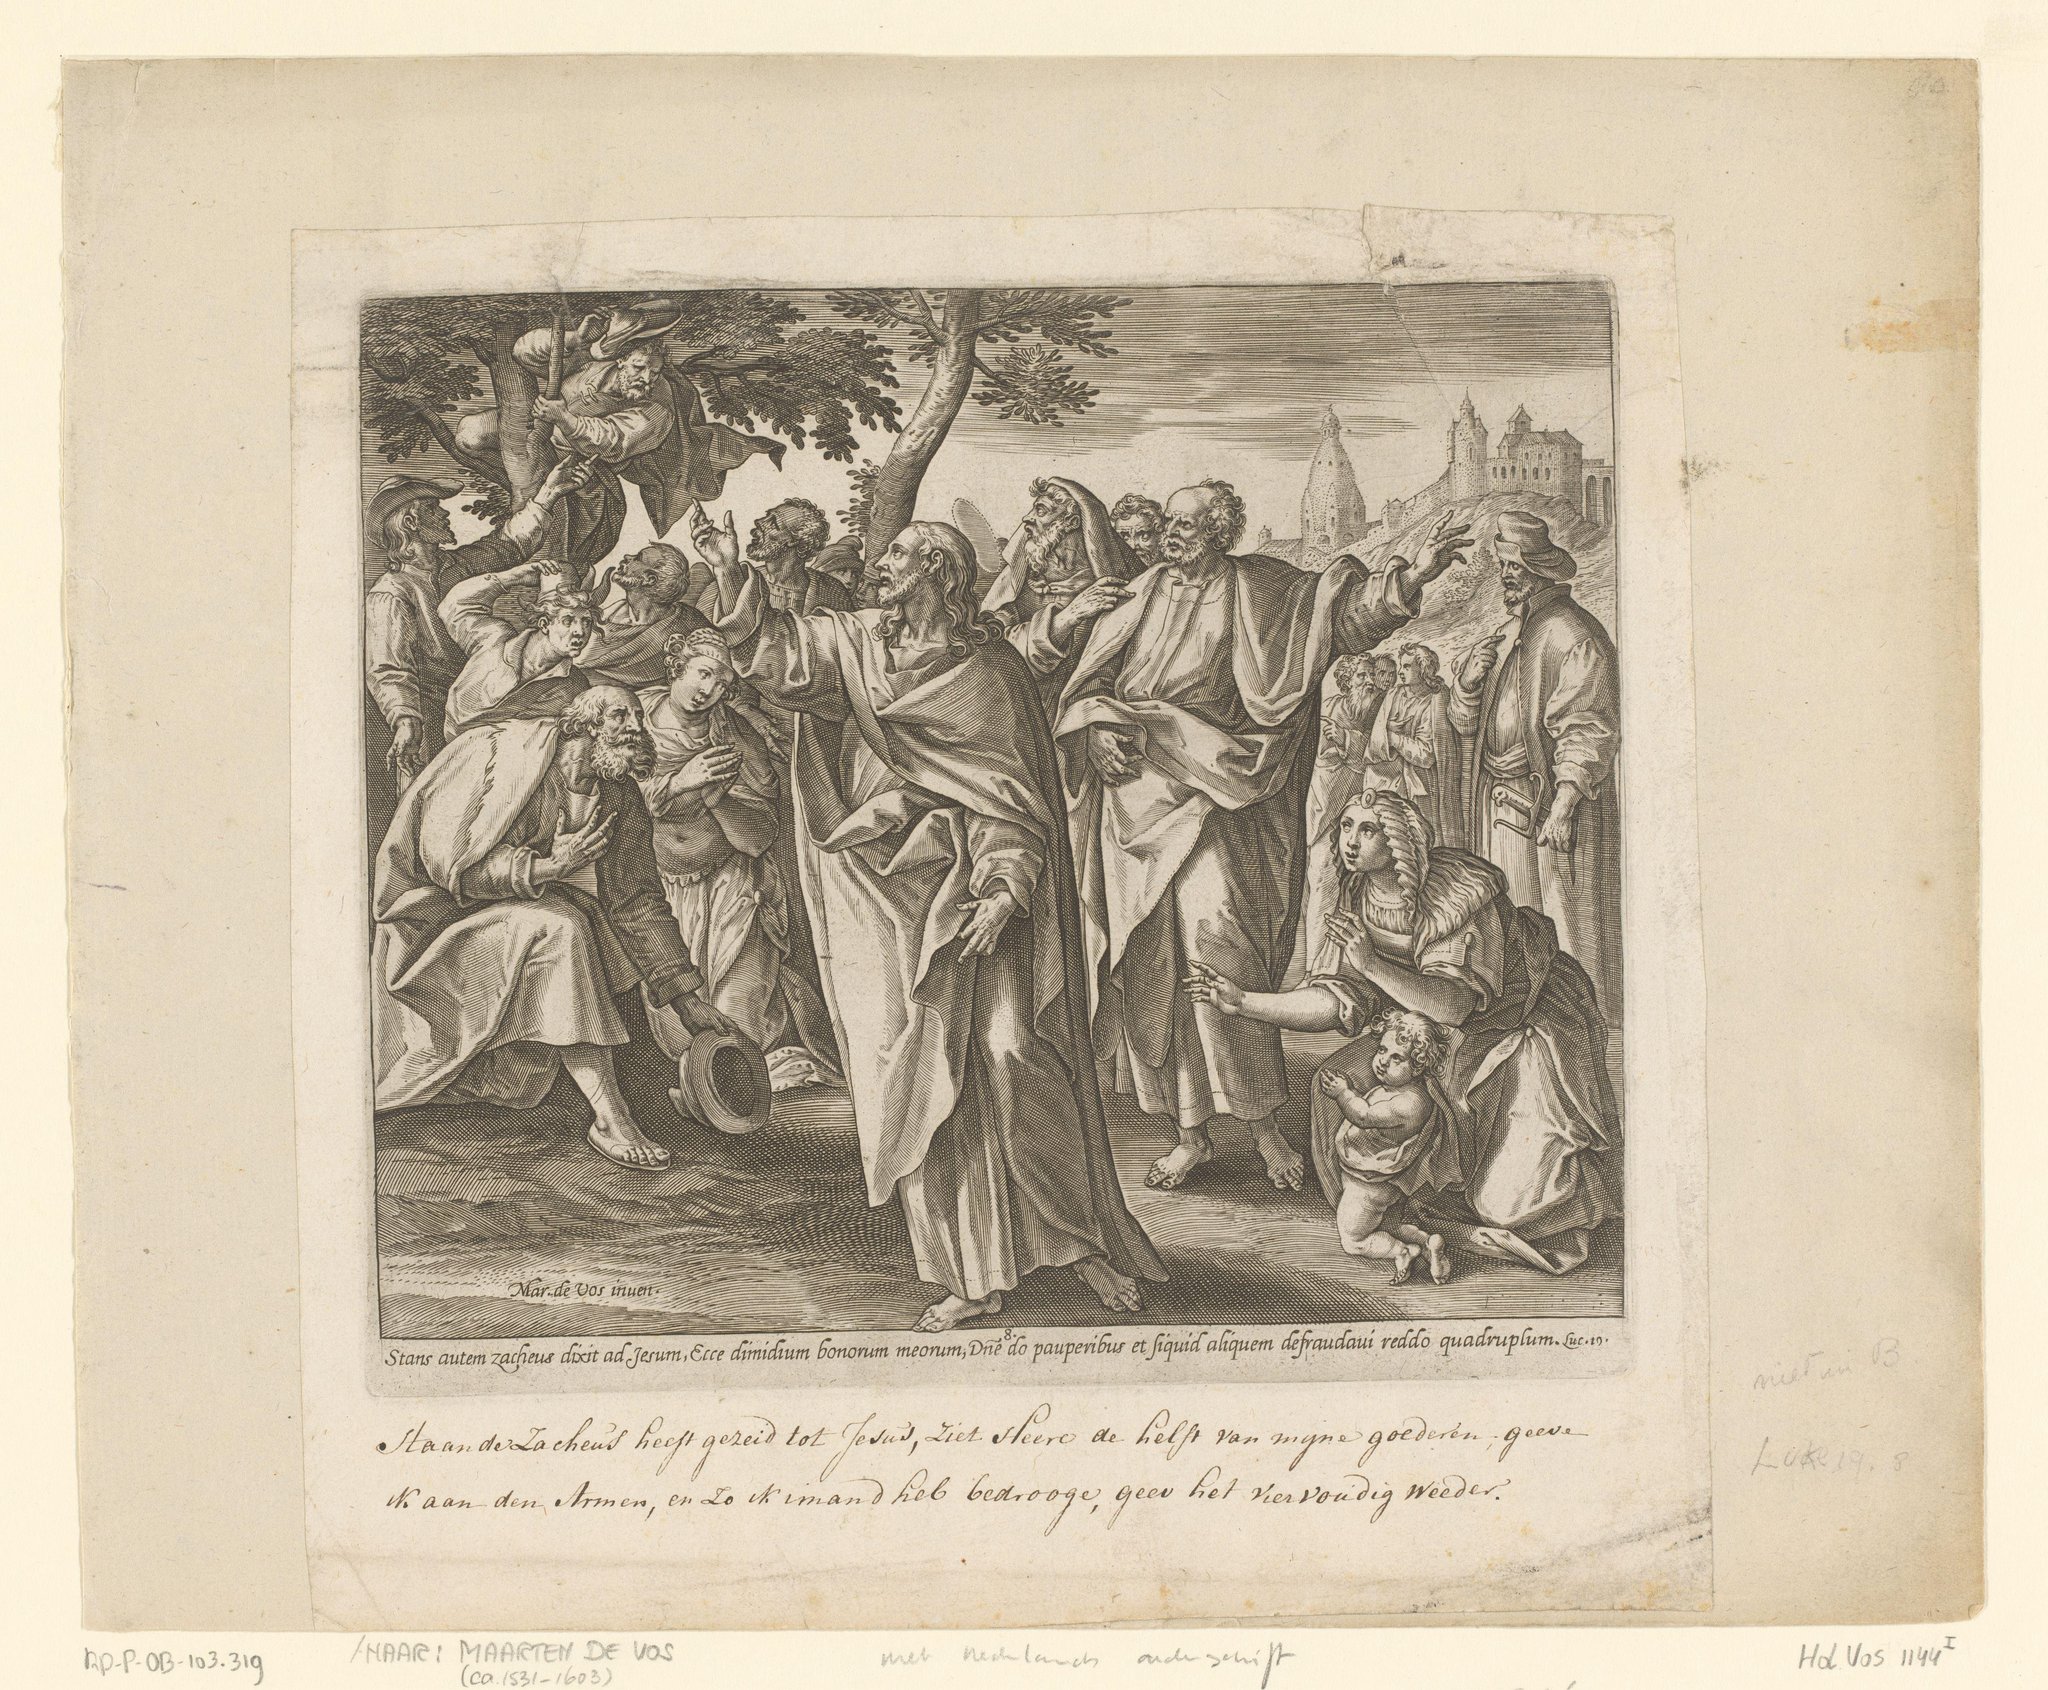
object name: print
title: Boetedoening en berouw in het Oude Testament en het Nieuwe Testament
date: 1547-1612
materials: paper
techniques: engraving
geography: antwerp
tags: calling of zacchaeus, who is sitting in a fig-tree (christ passing through jericho)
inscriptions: inscription: ‘Staande Zacheus heeft gezeid tot Jesus, ziet Heere de helft van mijne goederen geeve ik aan den Armen, en zo ik imand heb bedrooge, geev het viervoudig weeder’, collector's mark: Lugt 2228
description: De tollenaar Zacheus is in een boom gekropen om Christus te zien bij zijn intocht in Jericho. Christus roept Zacheus bij zich en vergeeft zijn zonden nadat hij berouw heeft getoond. De prent heeft een Latijns en (handgeschreven) Nederlands onderschrift.